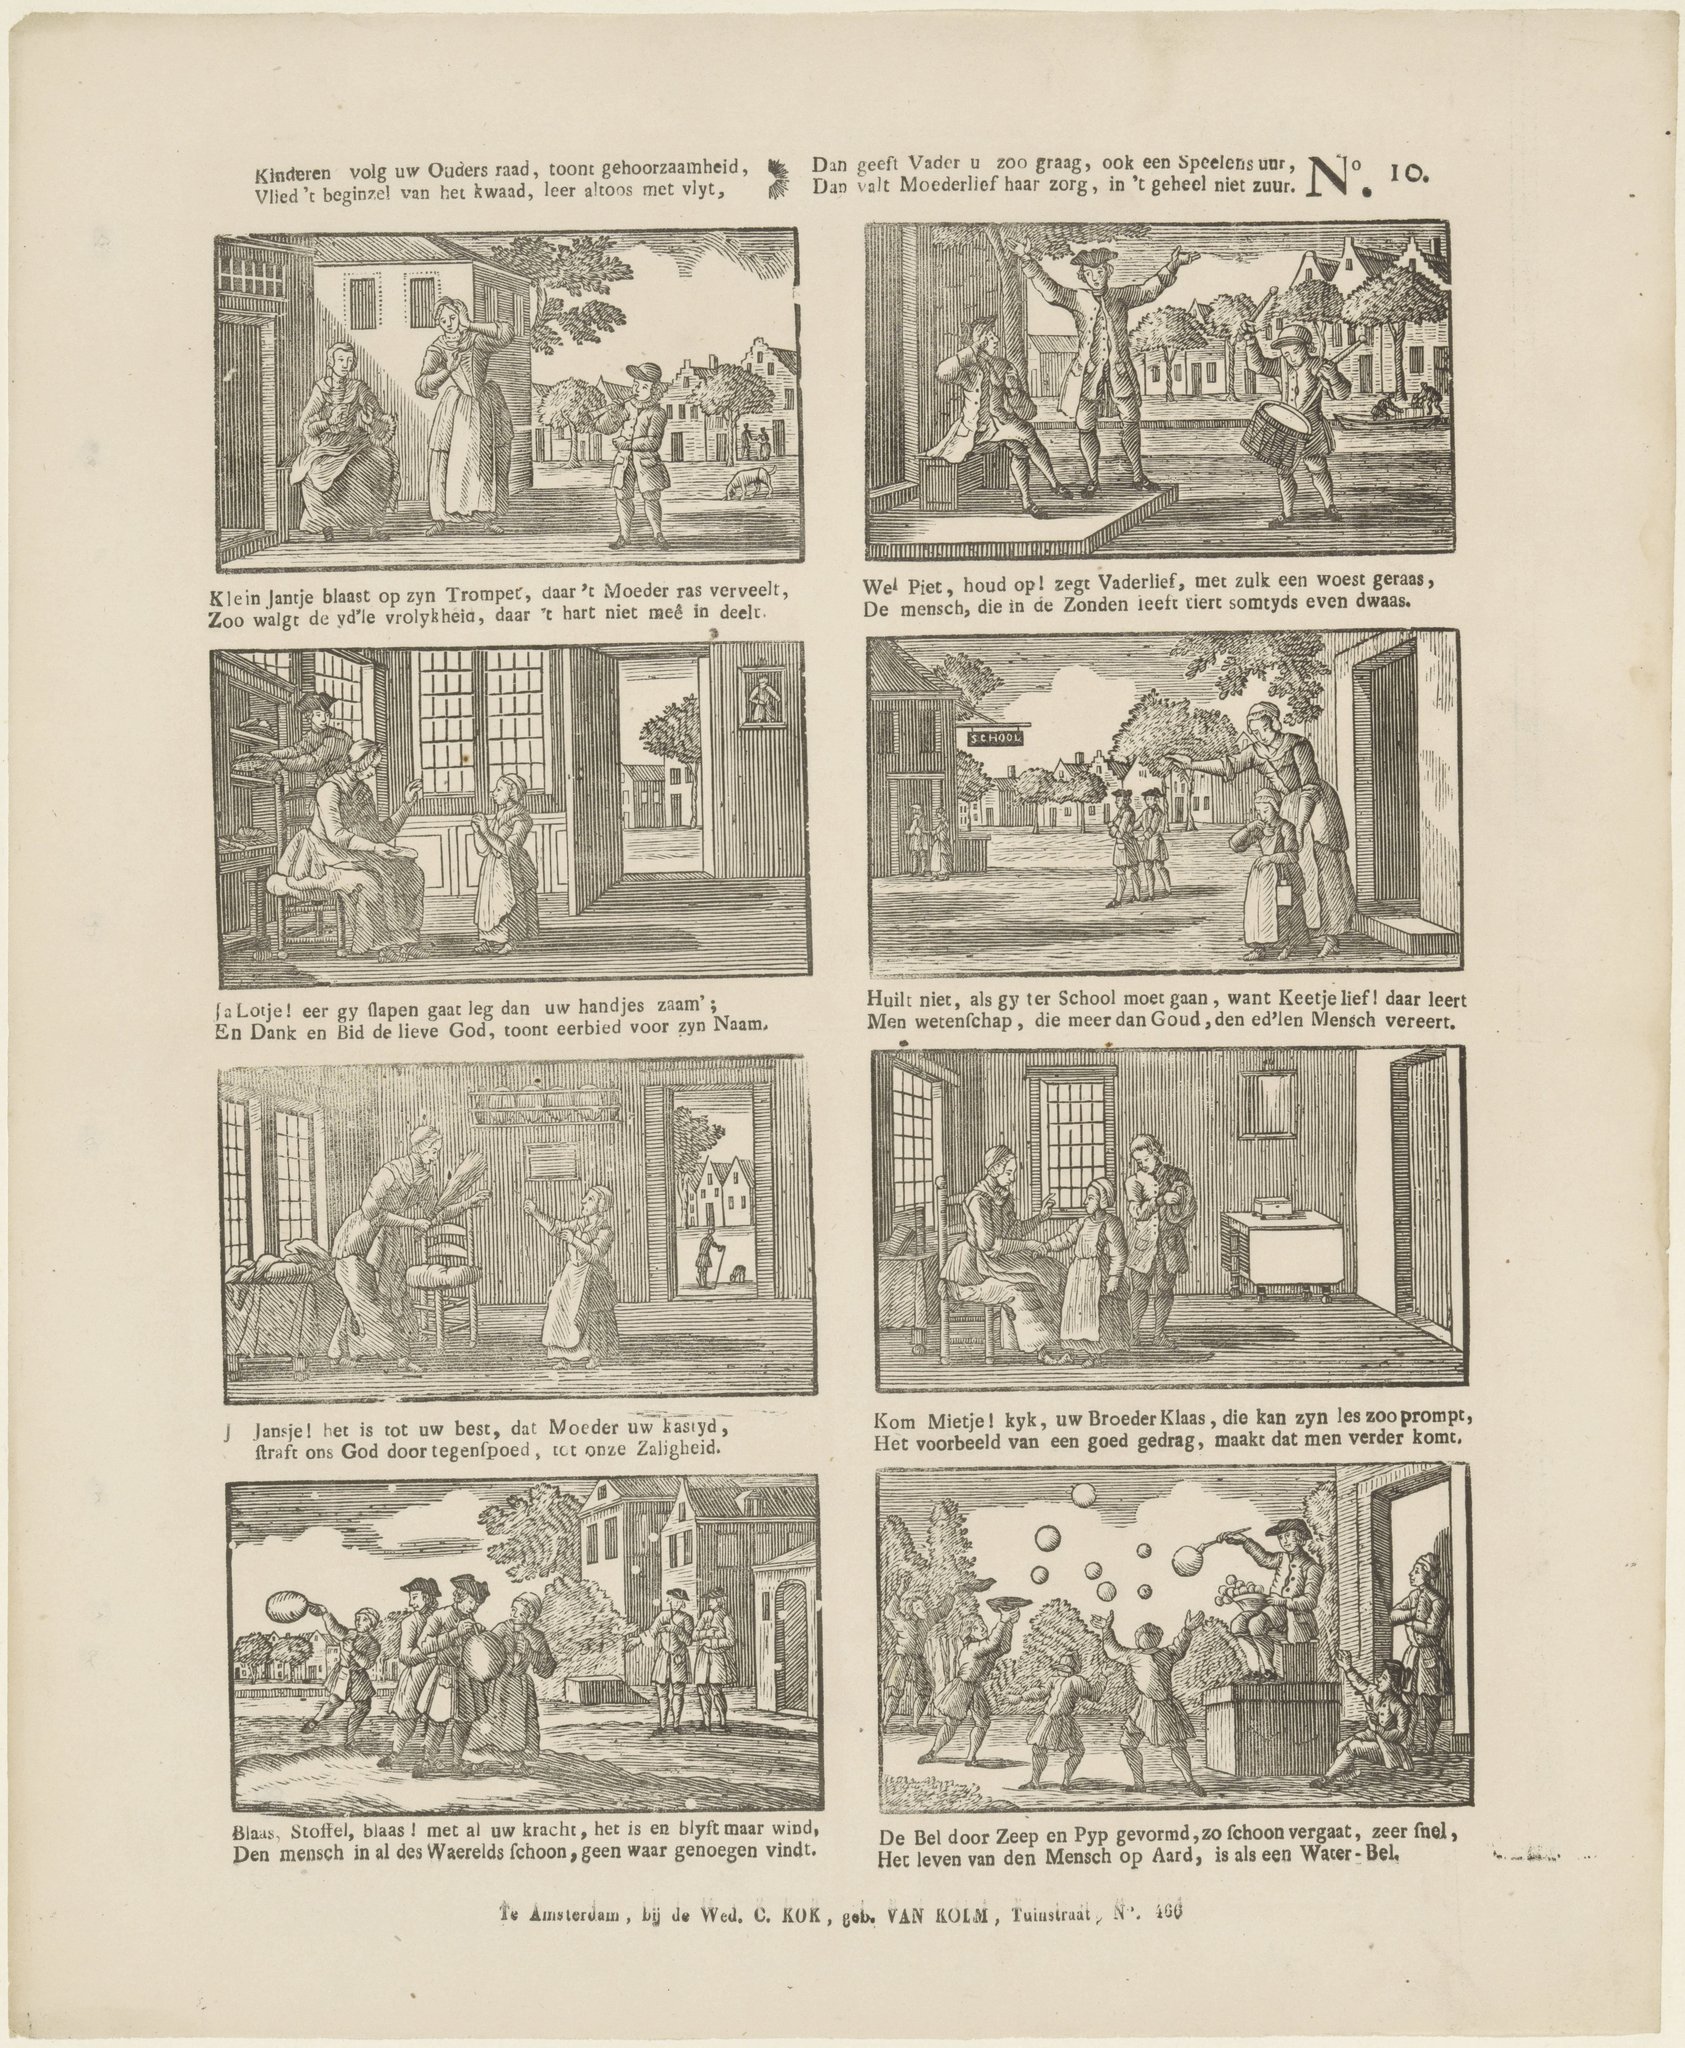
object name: popular print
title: Kinderen volg uw ouders raad, toont gehoorzaamheid, / Vlied 't beginzel van het kwaad, leer altoos met vlyt, / Dan geeft vader u zoo graag, ook een speelens uur, / Dan valt moederlief haar zorg, in 't geheel niet zuur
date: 1842-1866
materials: paper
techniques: letterpress printing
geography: netherlands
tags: going to school, children's games and plays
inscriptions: collector's mark: Lugt 2760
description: Blad met 8 voorstellingen van bezigheden van kinderen, waaronder trommelen, naar school gaan en zeepbellen vangen. Onder elke afbeelding een tweeregelig vers. Genummerd rechtsboven: No 10.